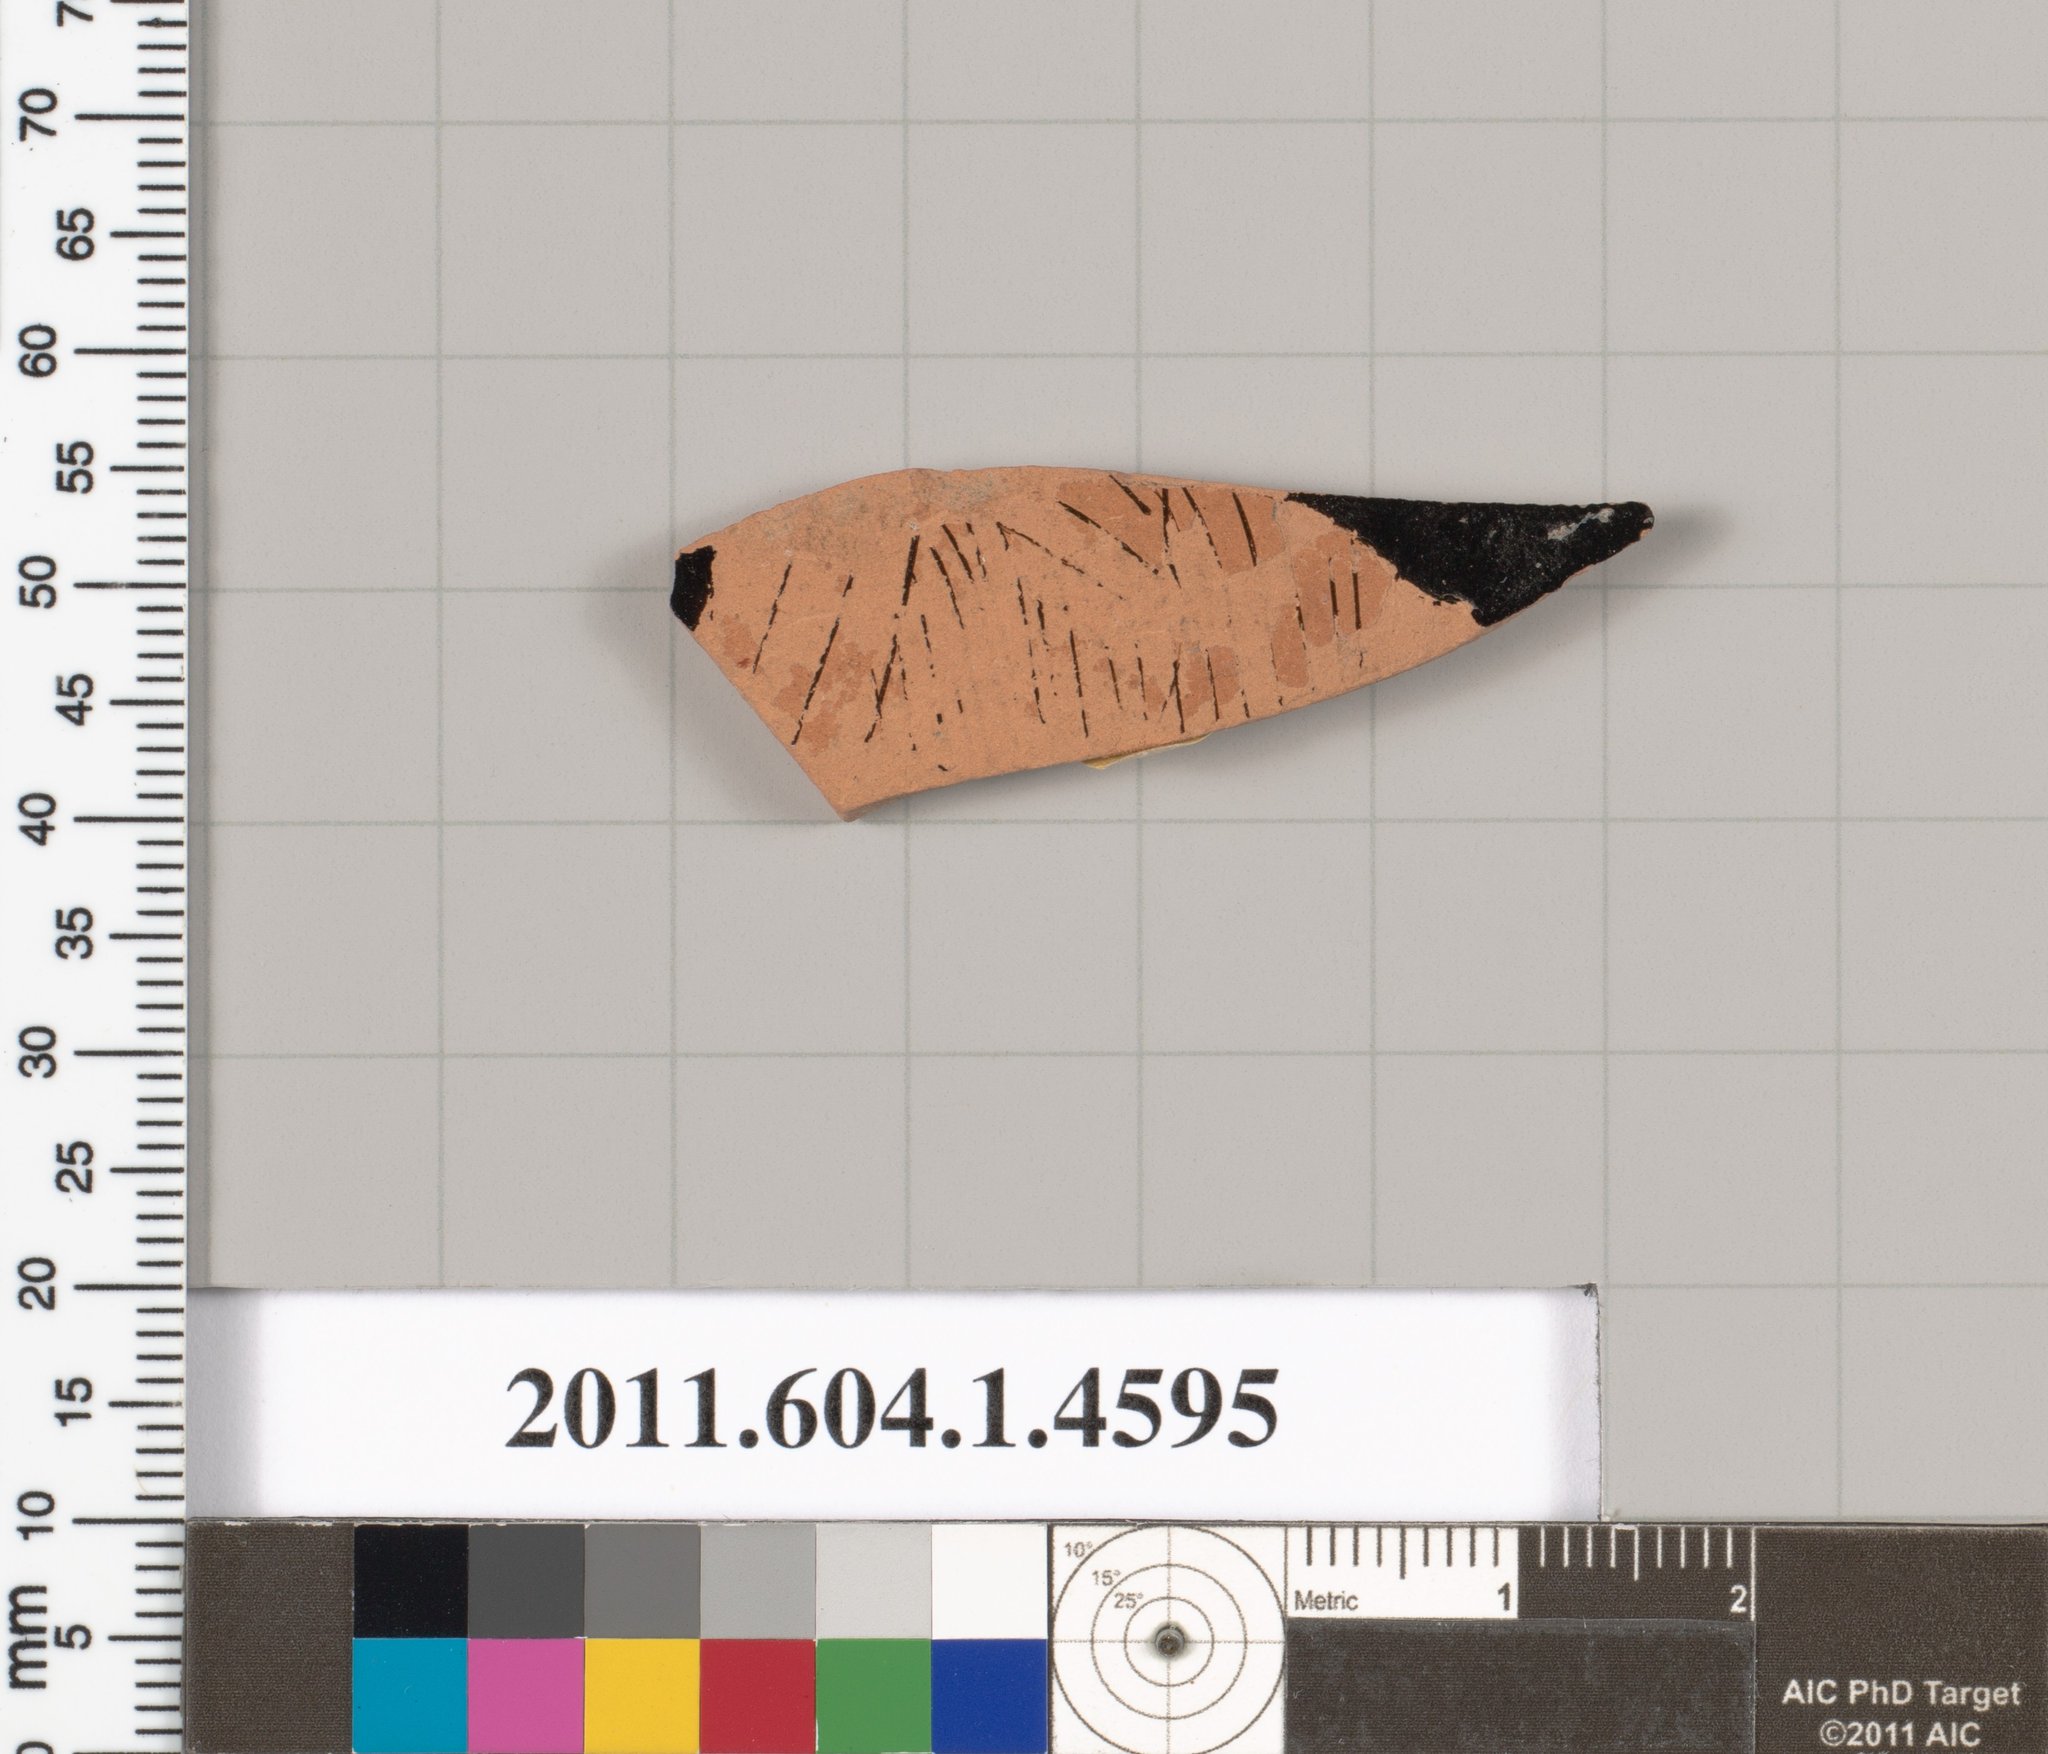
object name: kylix fragment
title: Terracotta fragment of a kylix (drinking cup)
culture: greek, attic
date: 490-470 BCE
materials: terracotta